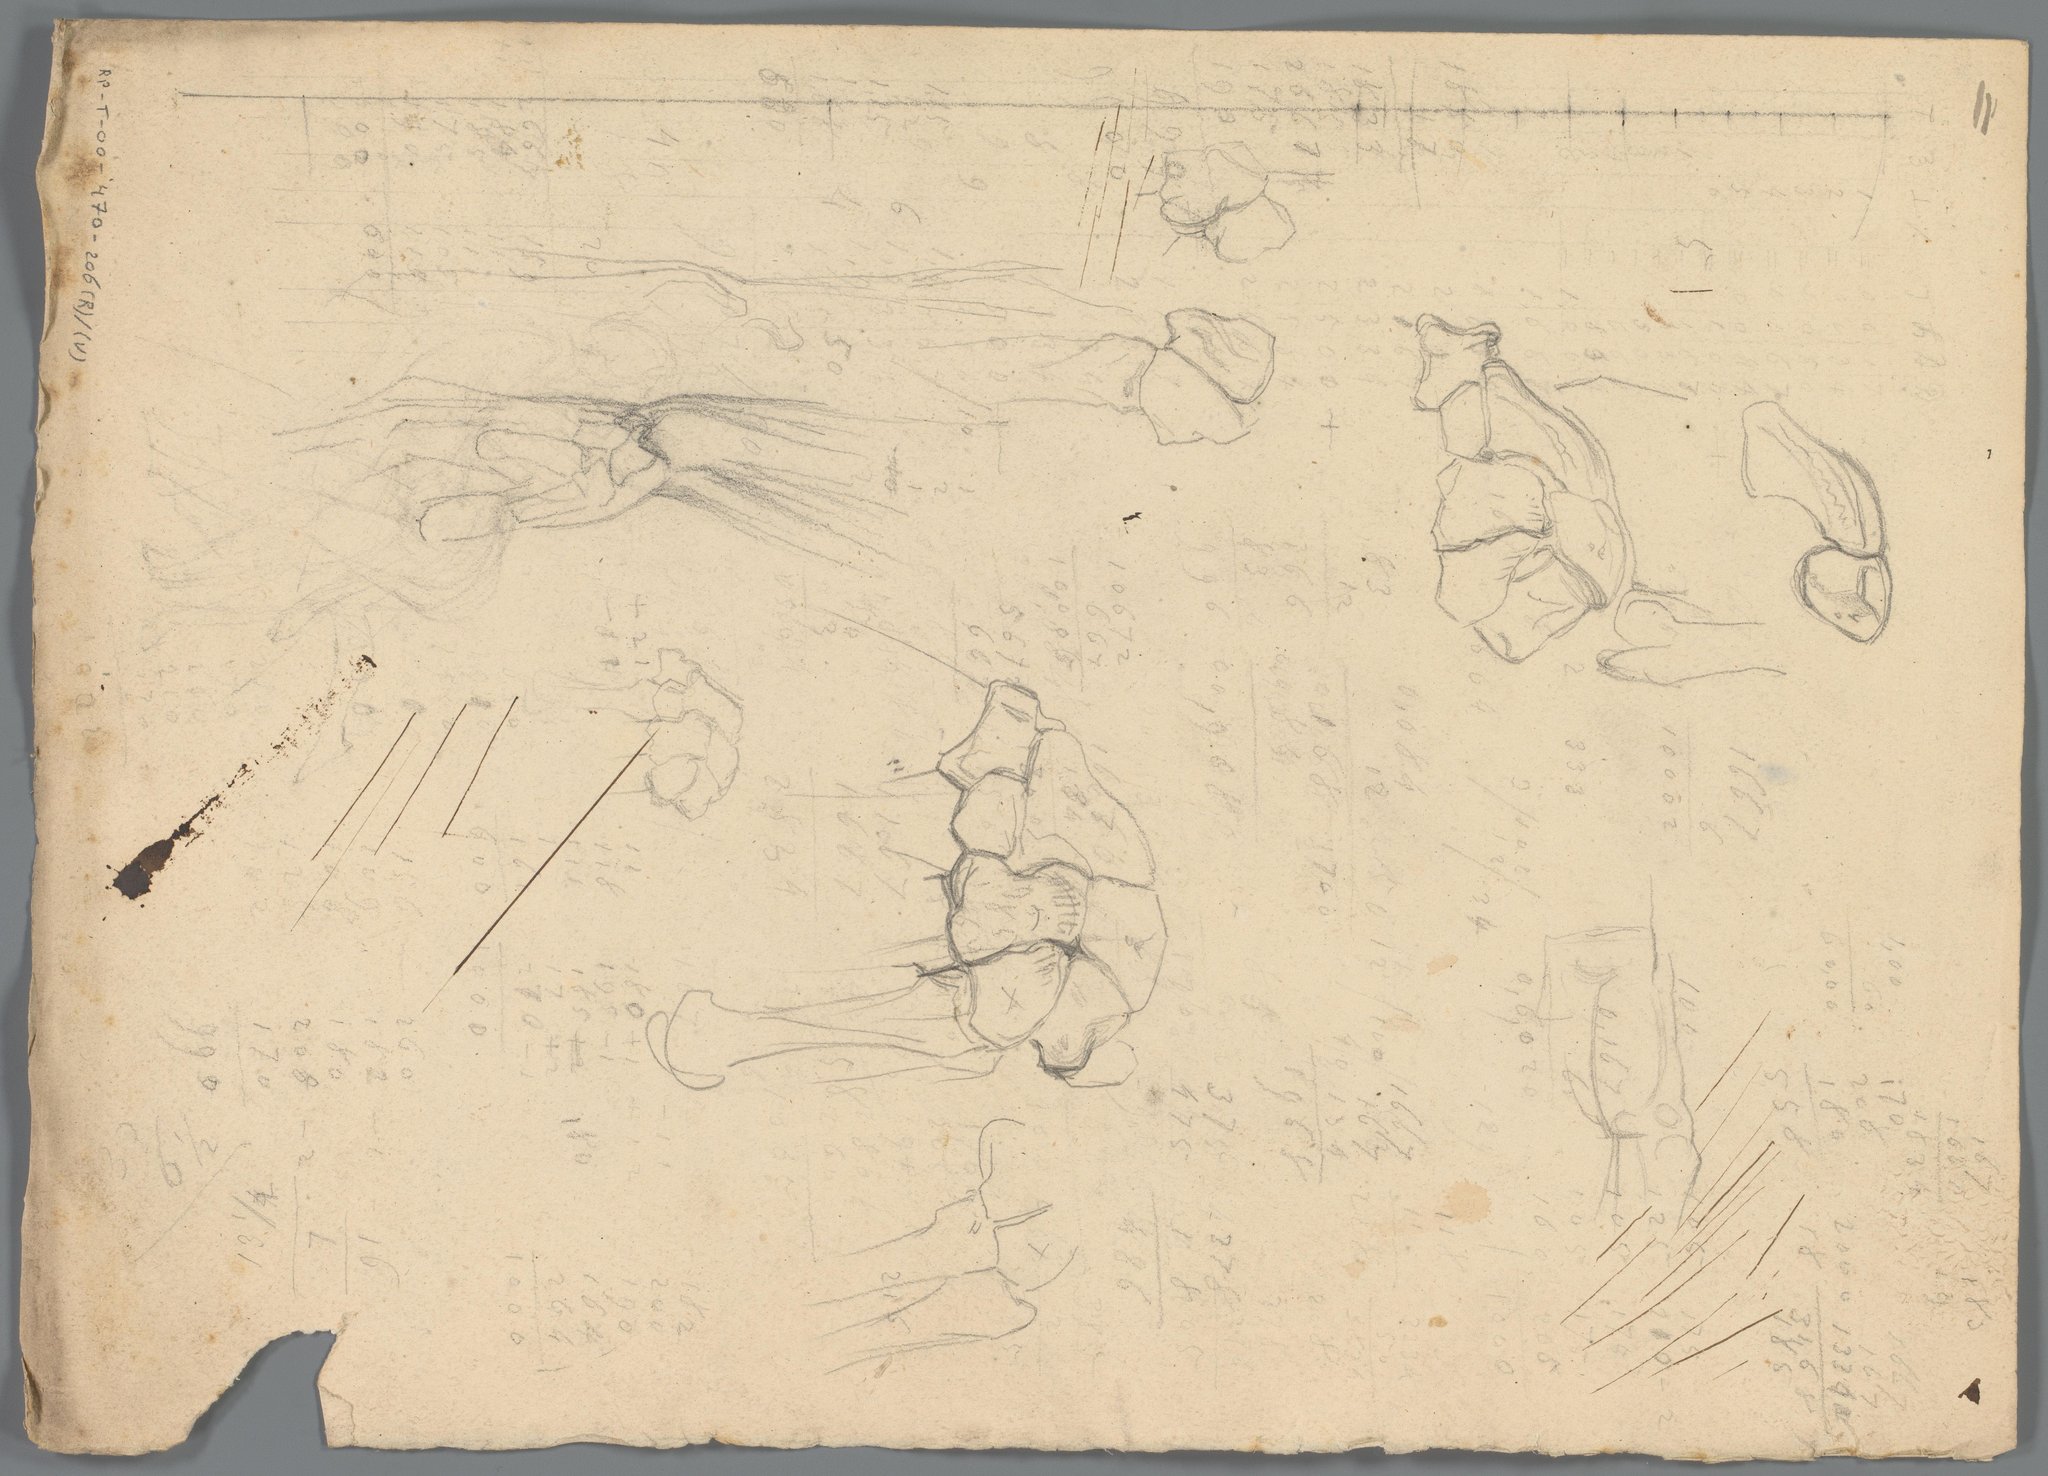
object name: drawing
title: Anatomische studie van botten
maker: jacobus everhardus josephus van den berg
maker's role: draughtsman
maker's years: 1802-1861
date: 1812-1861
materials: ink, paper, pencil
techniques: pen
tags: (human) skeleton